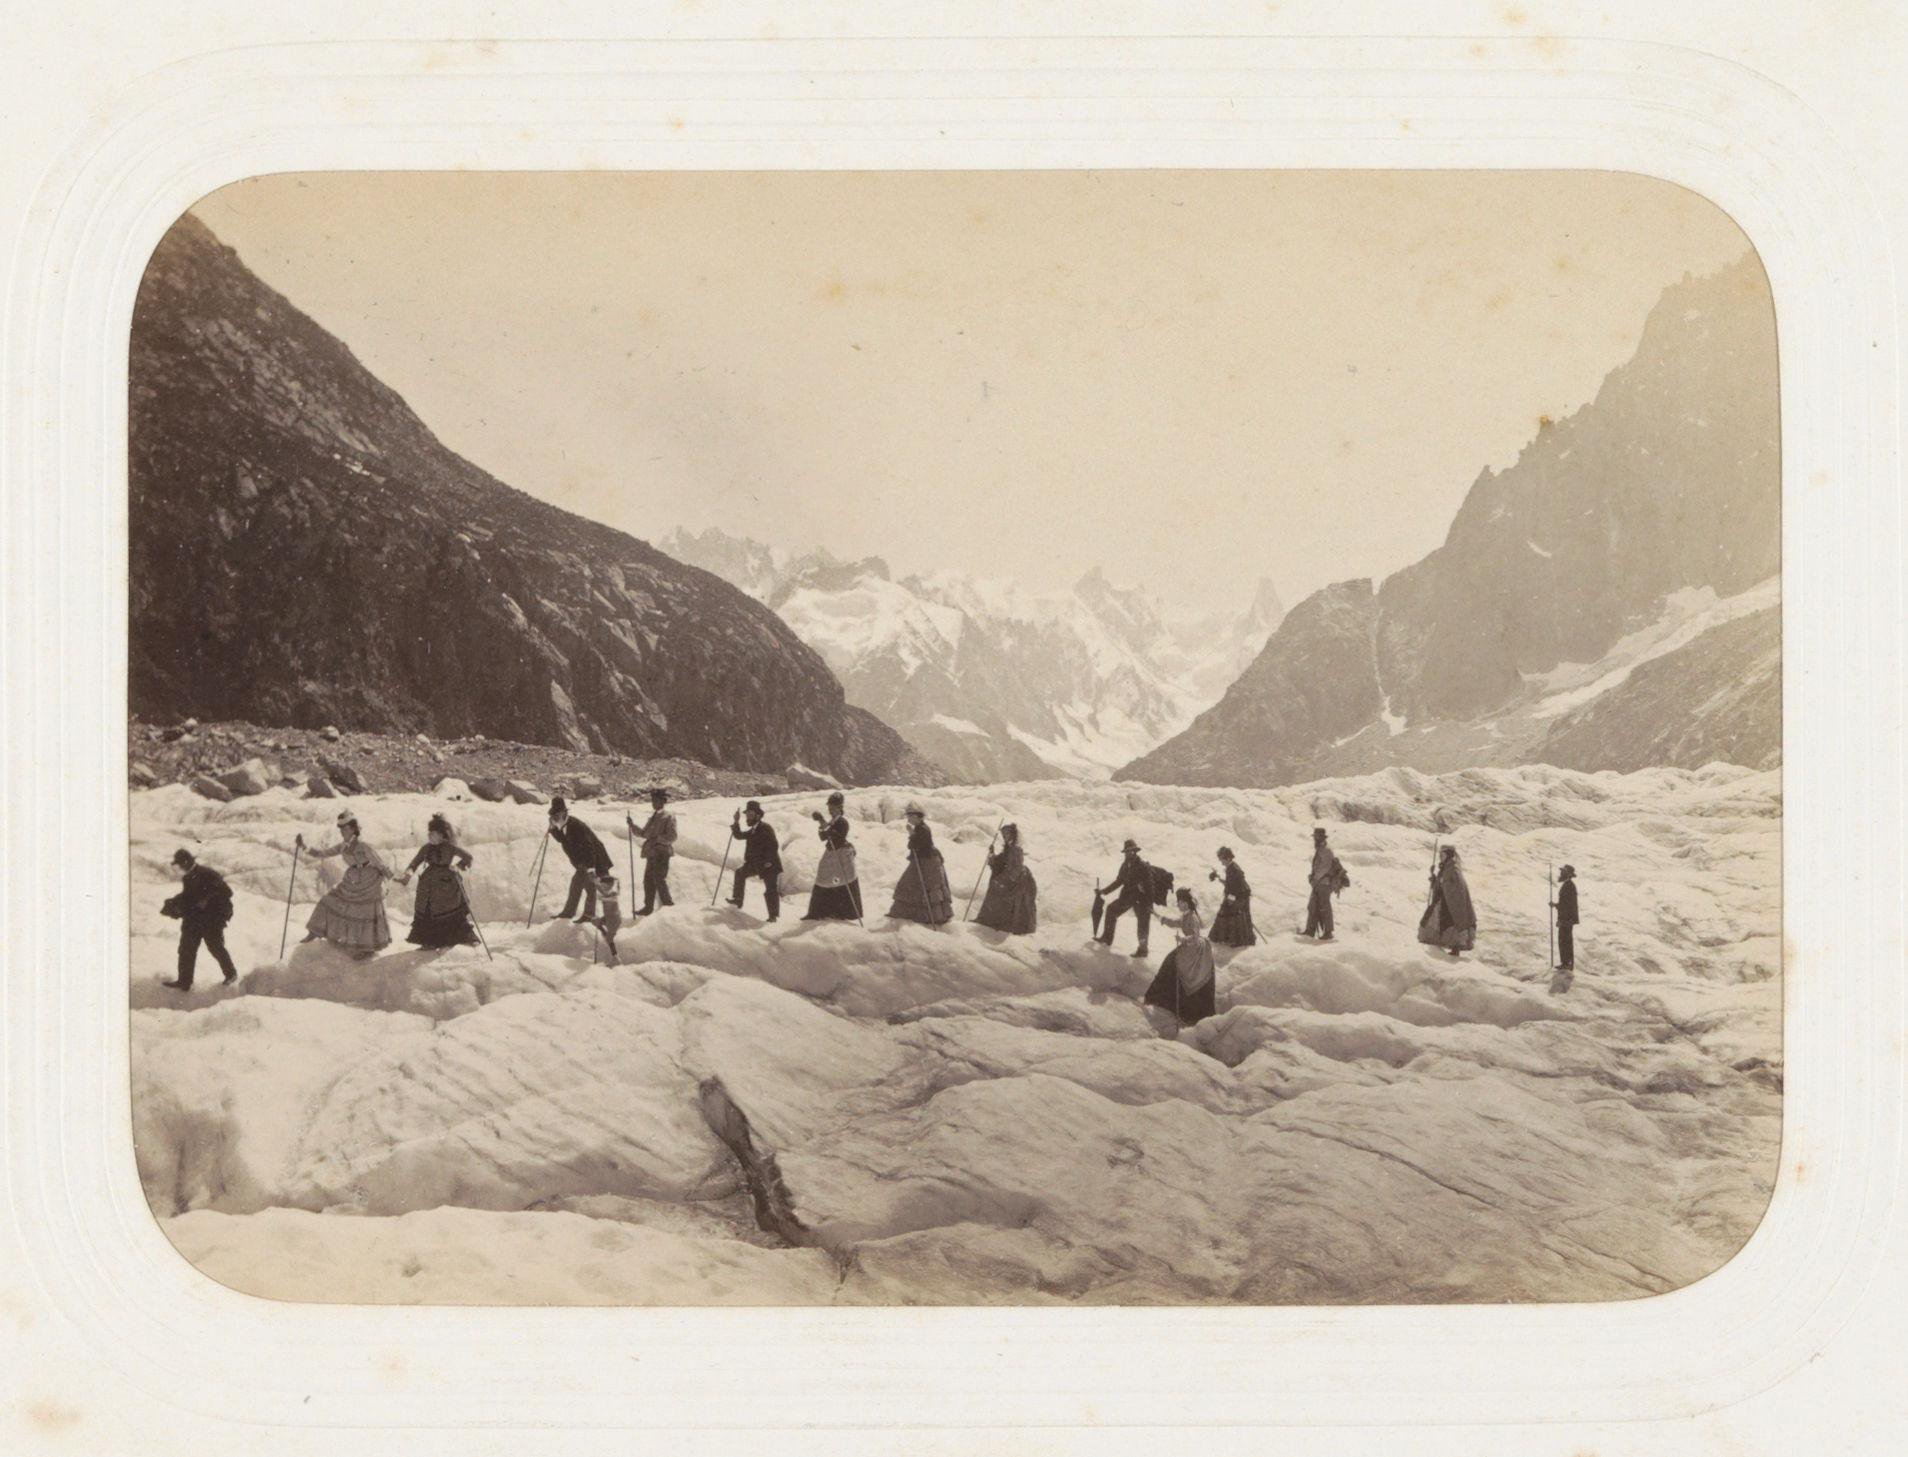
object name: photograph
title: Wandelaars steken het Mer de Glace over bij Chamonix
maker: auguste garcin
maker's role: fotograaf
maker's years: 1816-1895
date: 1860-1880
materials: cardboard, paper, photographic support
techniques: albumen print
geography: chamonix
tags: walking, hiking (recreation), glacier, mountains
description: Onderdeel van Reisalbum met bezienswaardigheden in de Zwitserse Alpen.